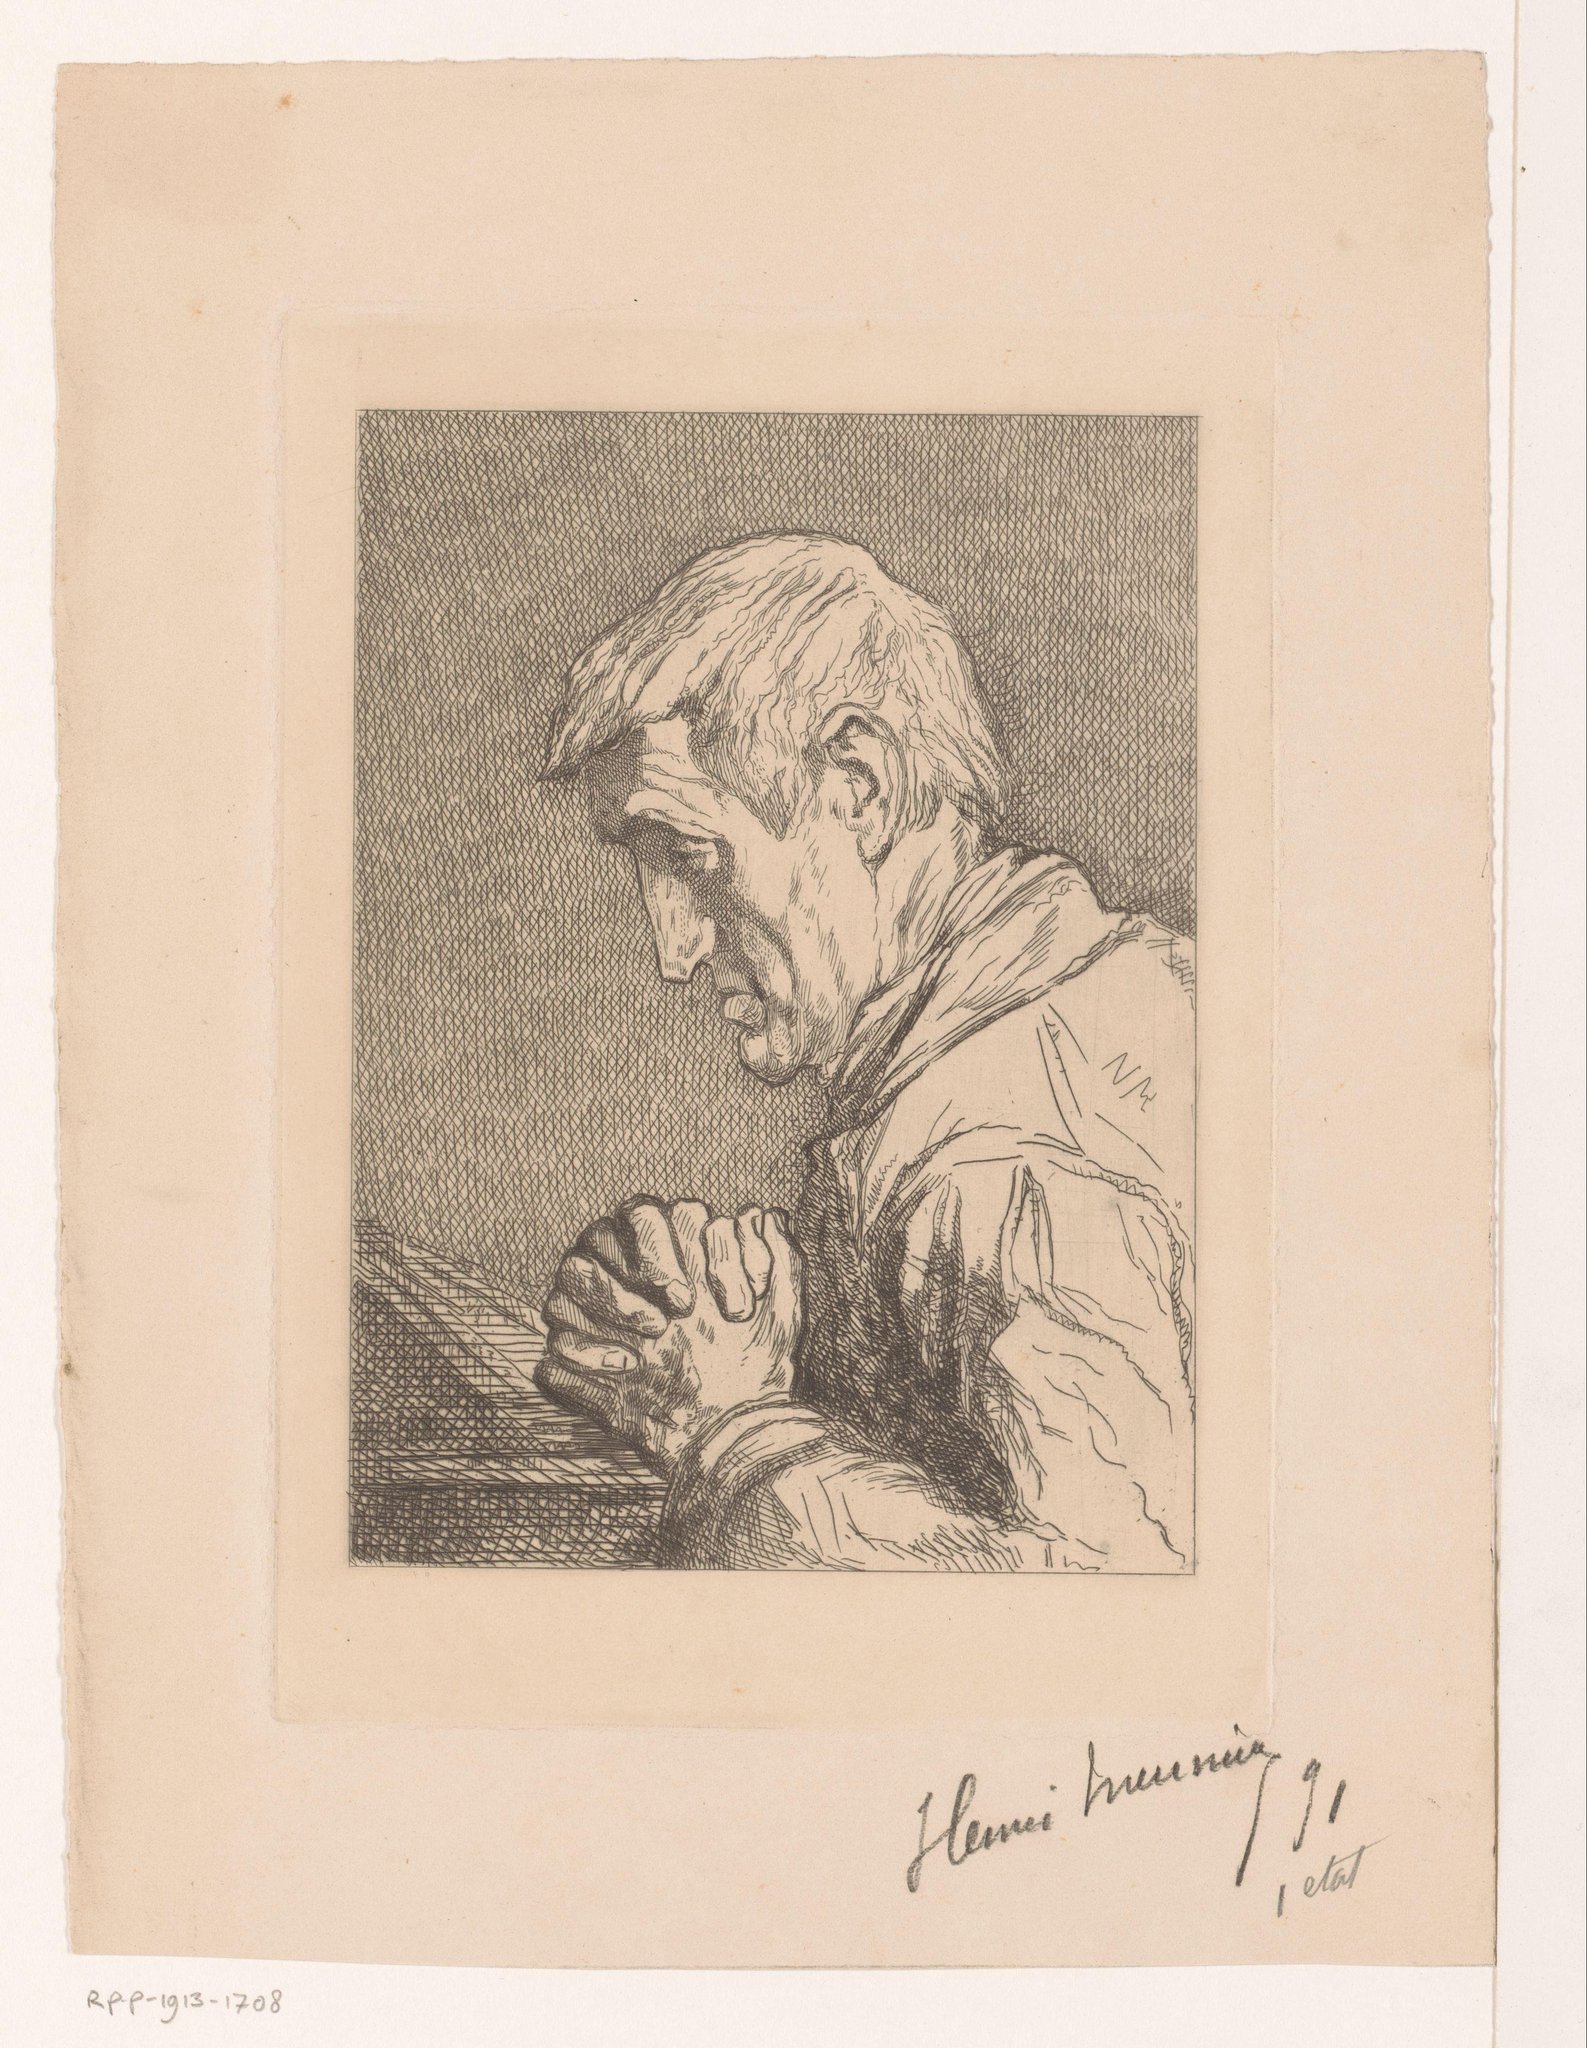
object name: print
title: Biddende man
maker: marc henry meunier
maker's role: print maker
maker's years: 1873-1922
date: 1891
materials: paper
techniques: etching, intaglio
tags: adult man, hands folded, one person praying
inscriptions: inscription: ‘1 etat’, collector's mark: Lugt 2228